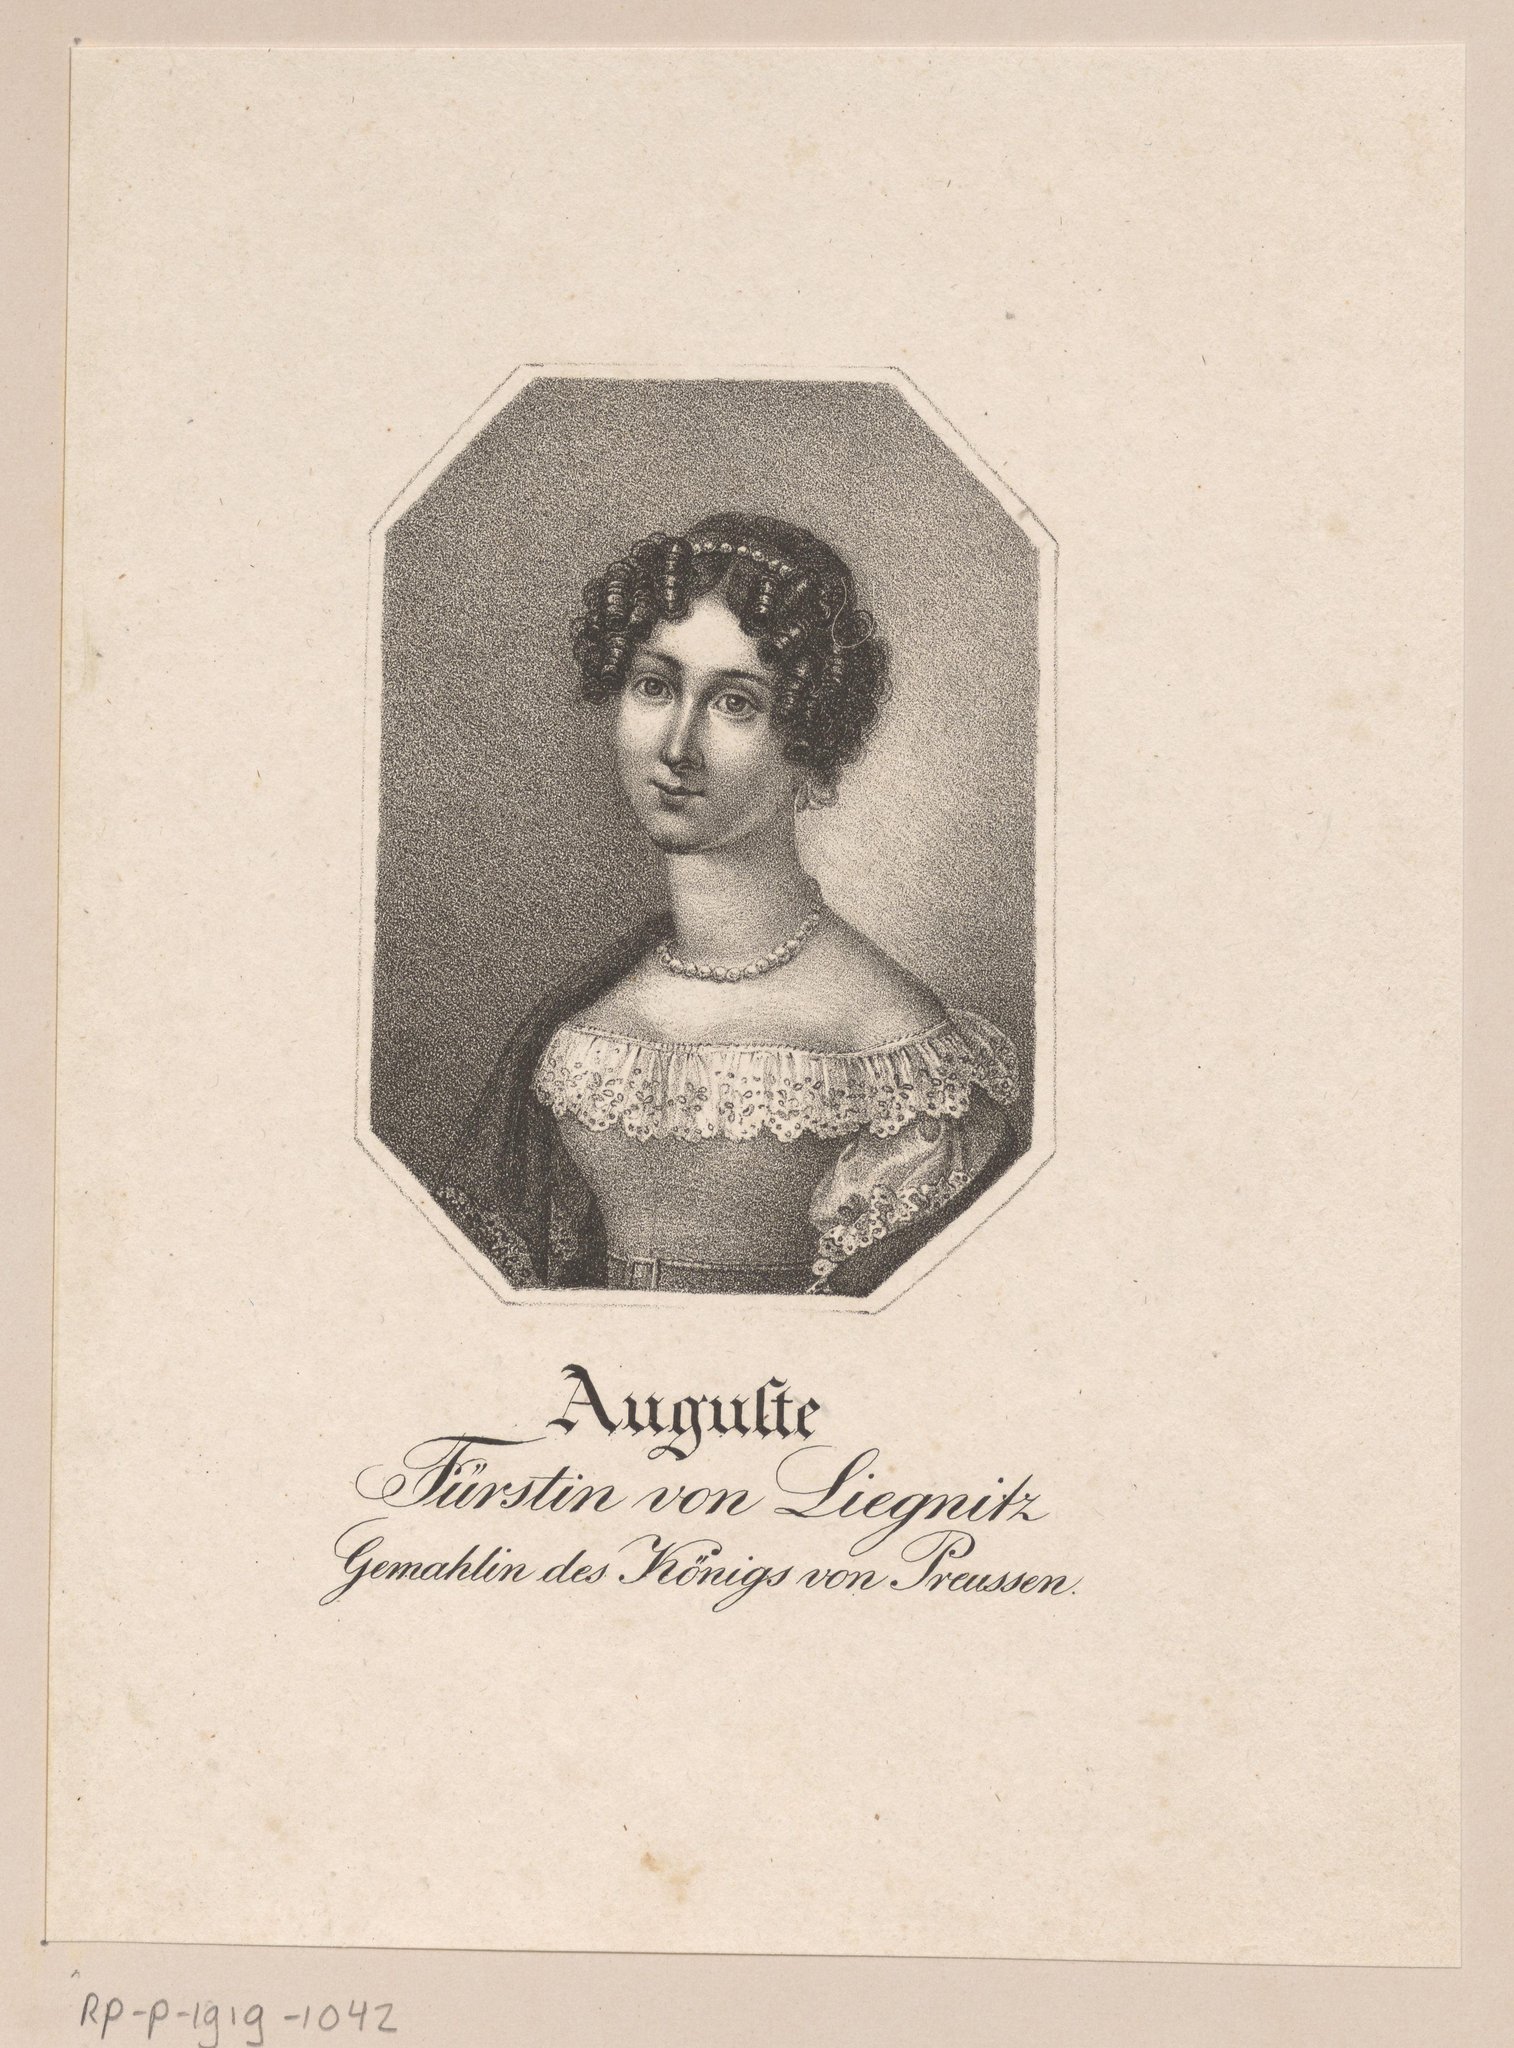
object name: print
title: Portret van Auguste von Harrach, vorstin van Liegnitz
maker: Anonymous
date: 1824-1850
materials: paper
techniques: lithograph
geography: germany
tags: historical persons - bb - woman, pearl; pearl necklace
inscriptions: collector's mark: Lugt 2228